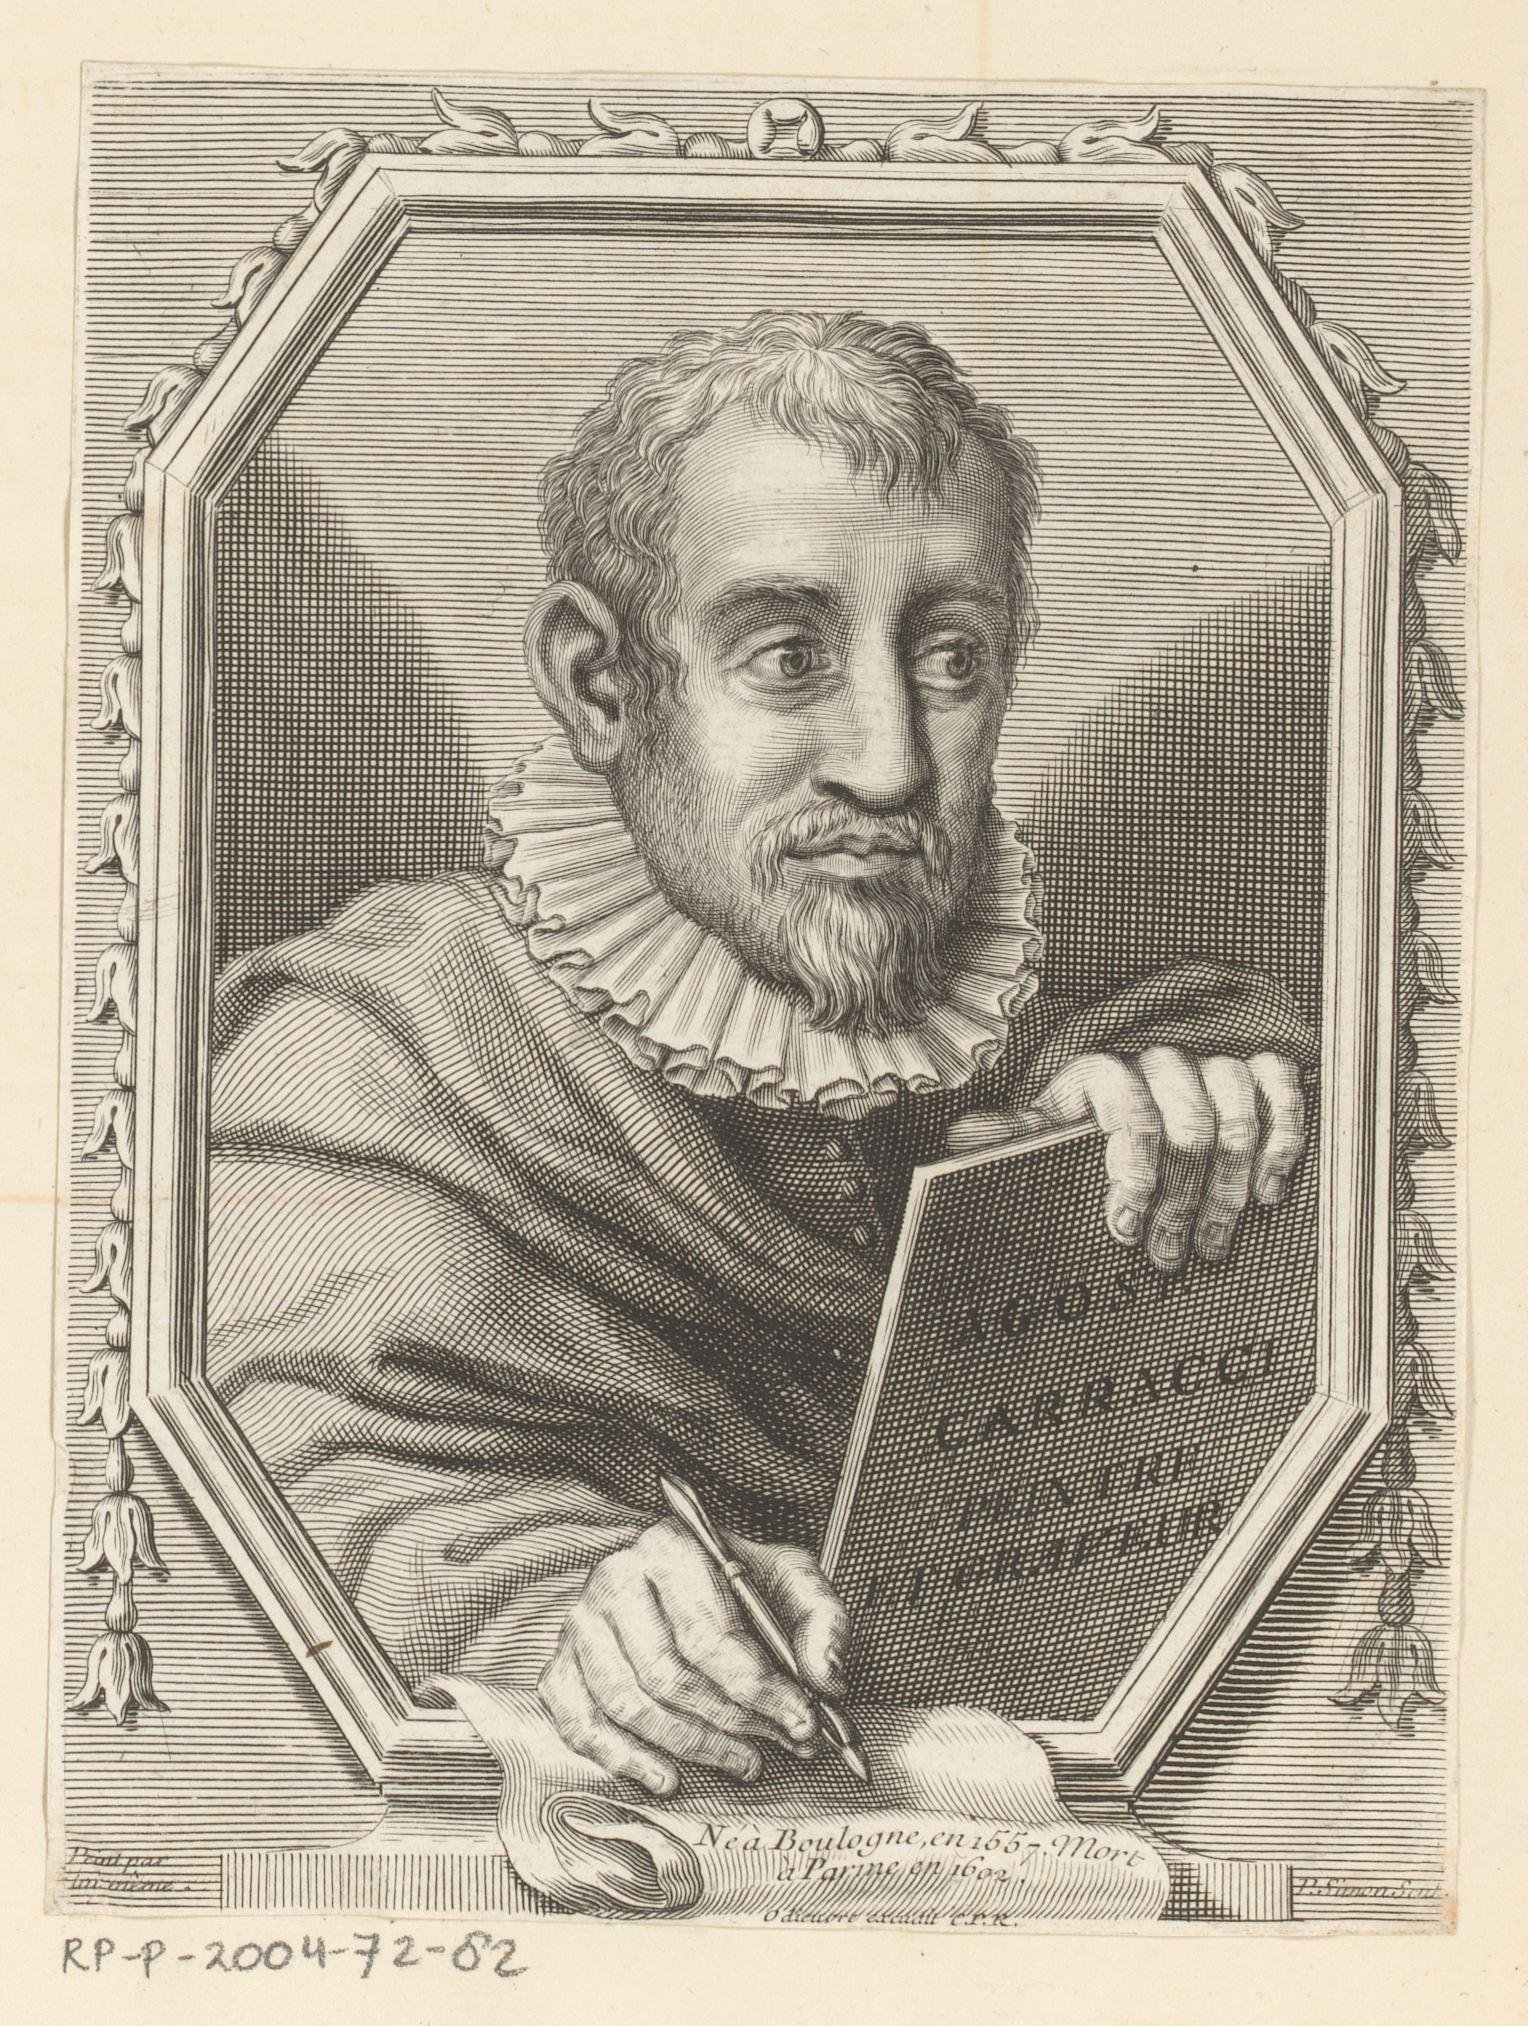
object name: print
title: Agost Carracci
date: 1777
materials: paper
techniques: engraving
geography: paris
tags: draughtsman, agostino carracci, historical persons, portrait, self-portrait of painter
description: Prent uit: Dreux du Radier, Jean-François. L'Europe illustré, contenant l'histoire abregée des souverains, des princes, des prélats, des ministres, (...) en Europe: dans le XVe. siècle compris, jusqu'à présent. 6 dln. Parijs: Jean-Luc Nyon, 1777, dl. 6. De samensteller heeft deze prent in het album geplakt als illustratie bij: Pilkington, Matthew en Johann Heinrich Füssli. A dictionary of painters, from the revival of the art to the present period. 4 dln. Londen: John Crowder, 1805, dl. 1, p. 104.